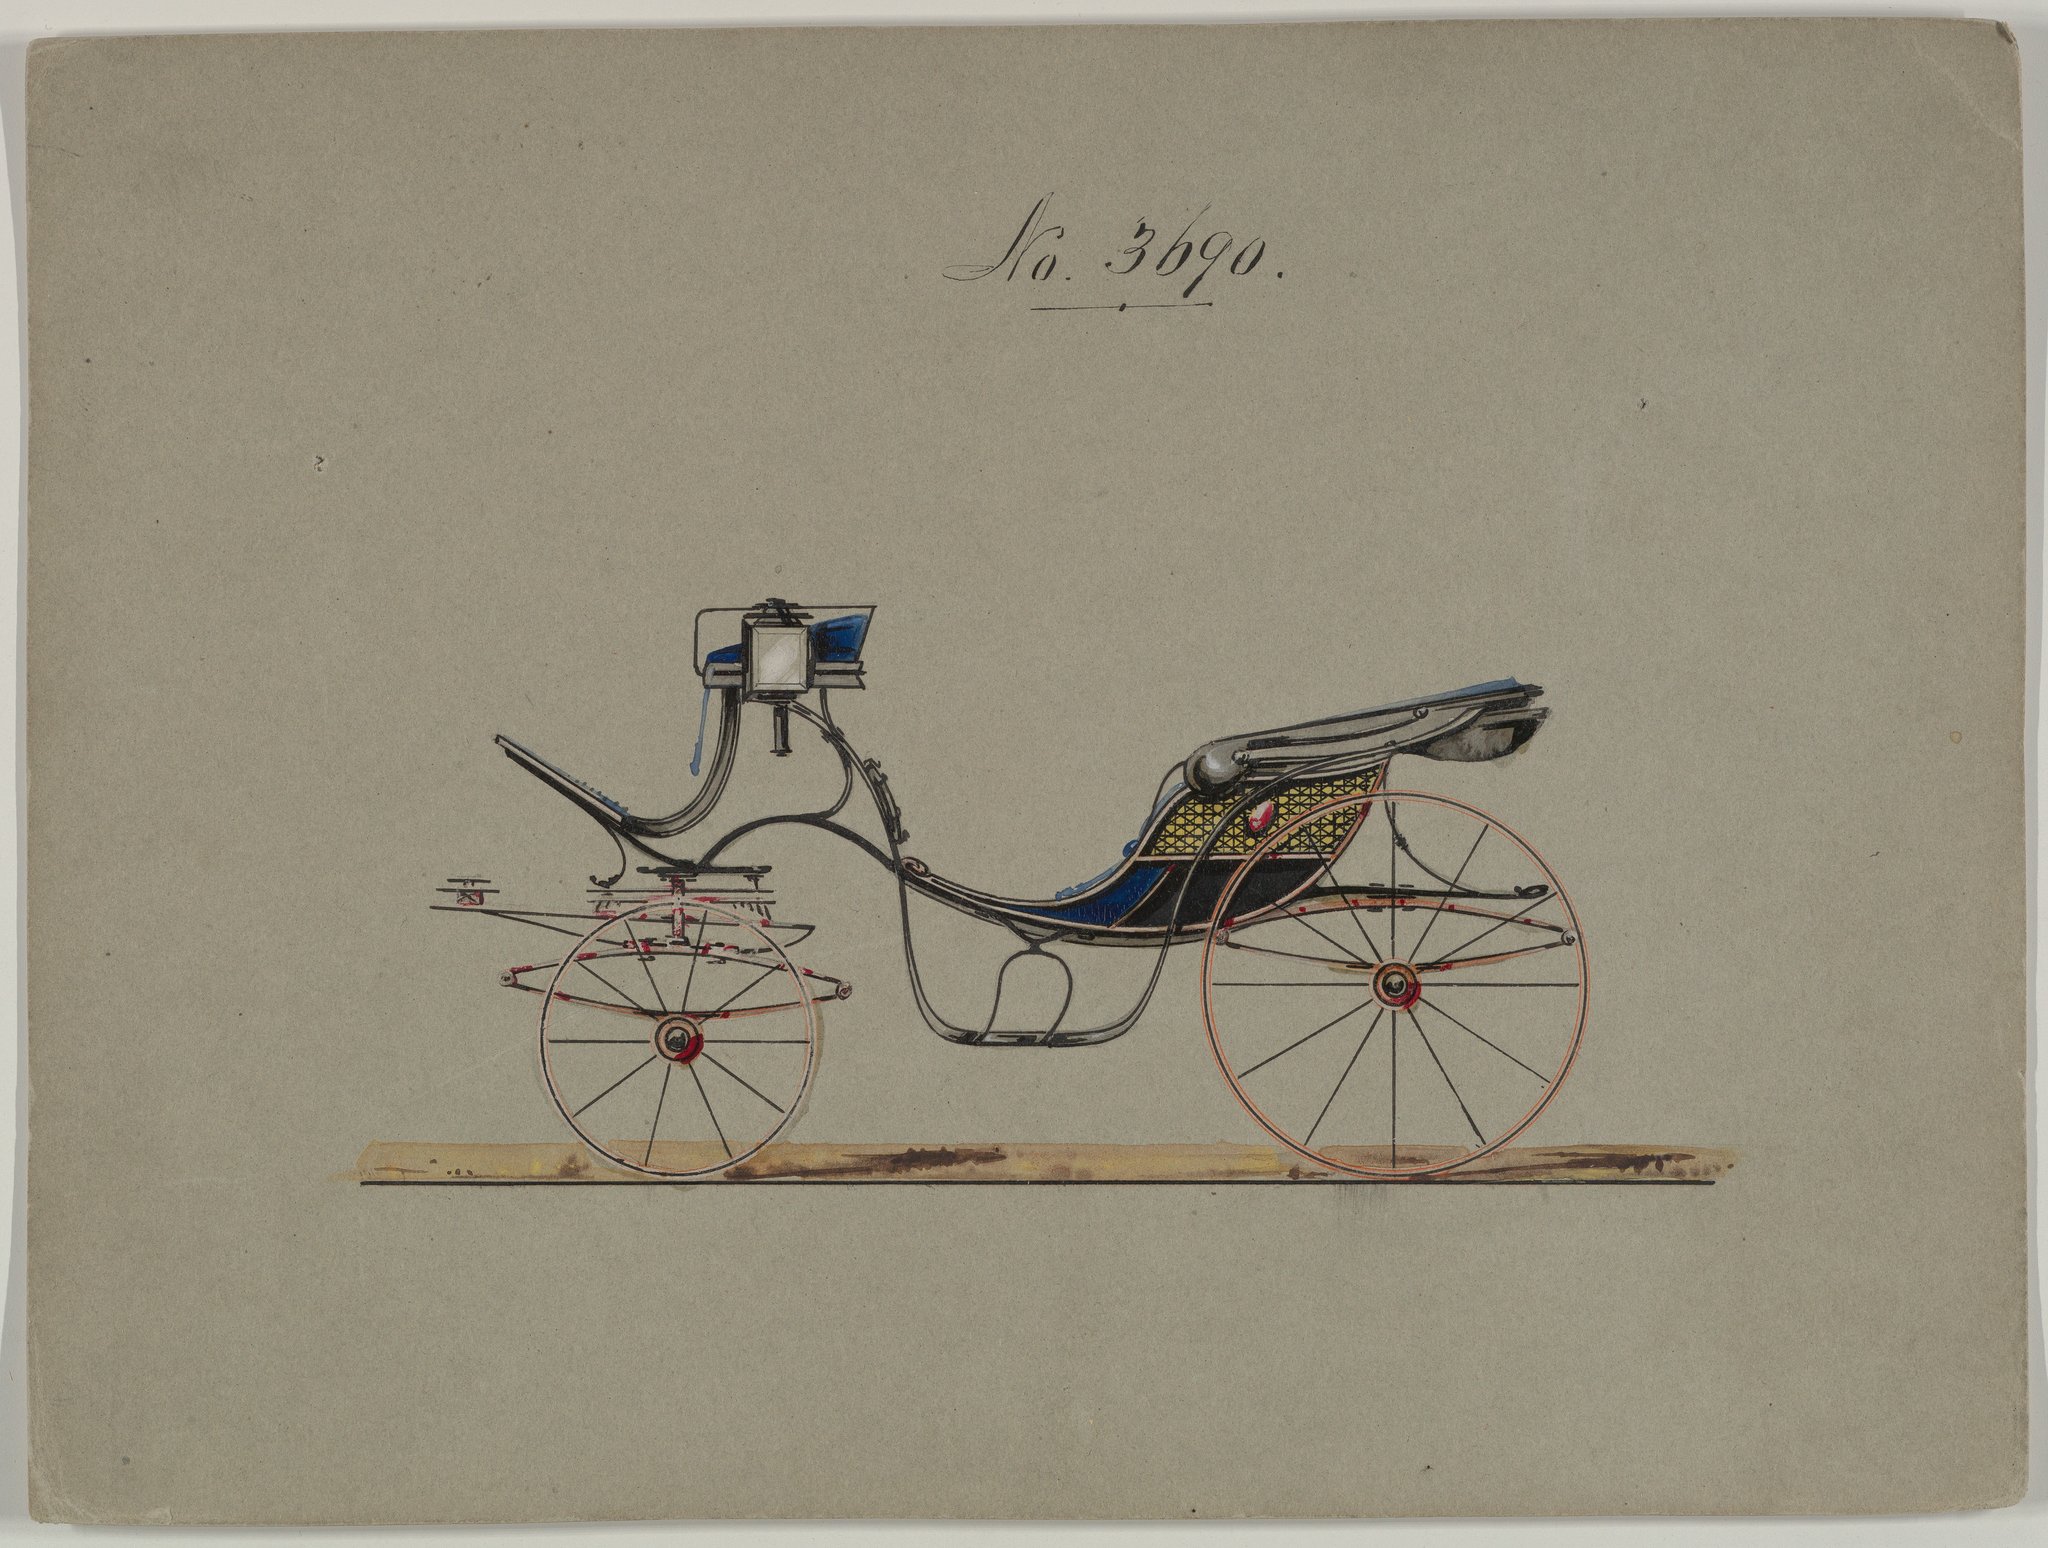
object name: drawing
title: Design for Cabriolet or Victoria, no. 3690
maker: brewster & co.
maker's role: manufacturer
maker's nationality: american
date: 1881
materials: gouache, ink, watercolor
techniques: pen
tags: carriages